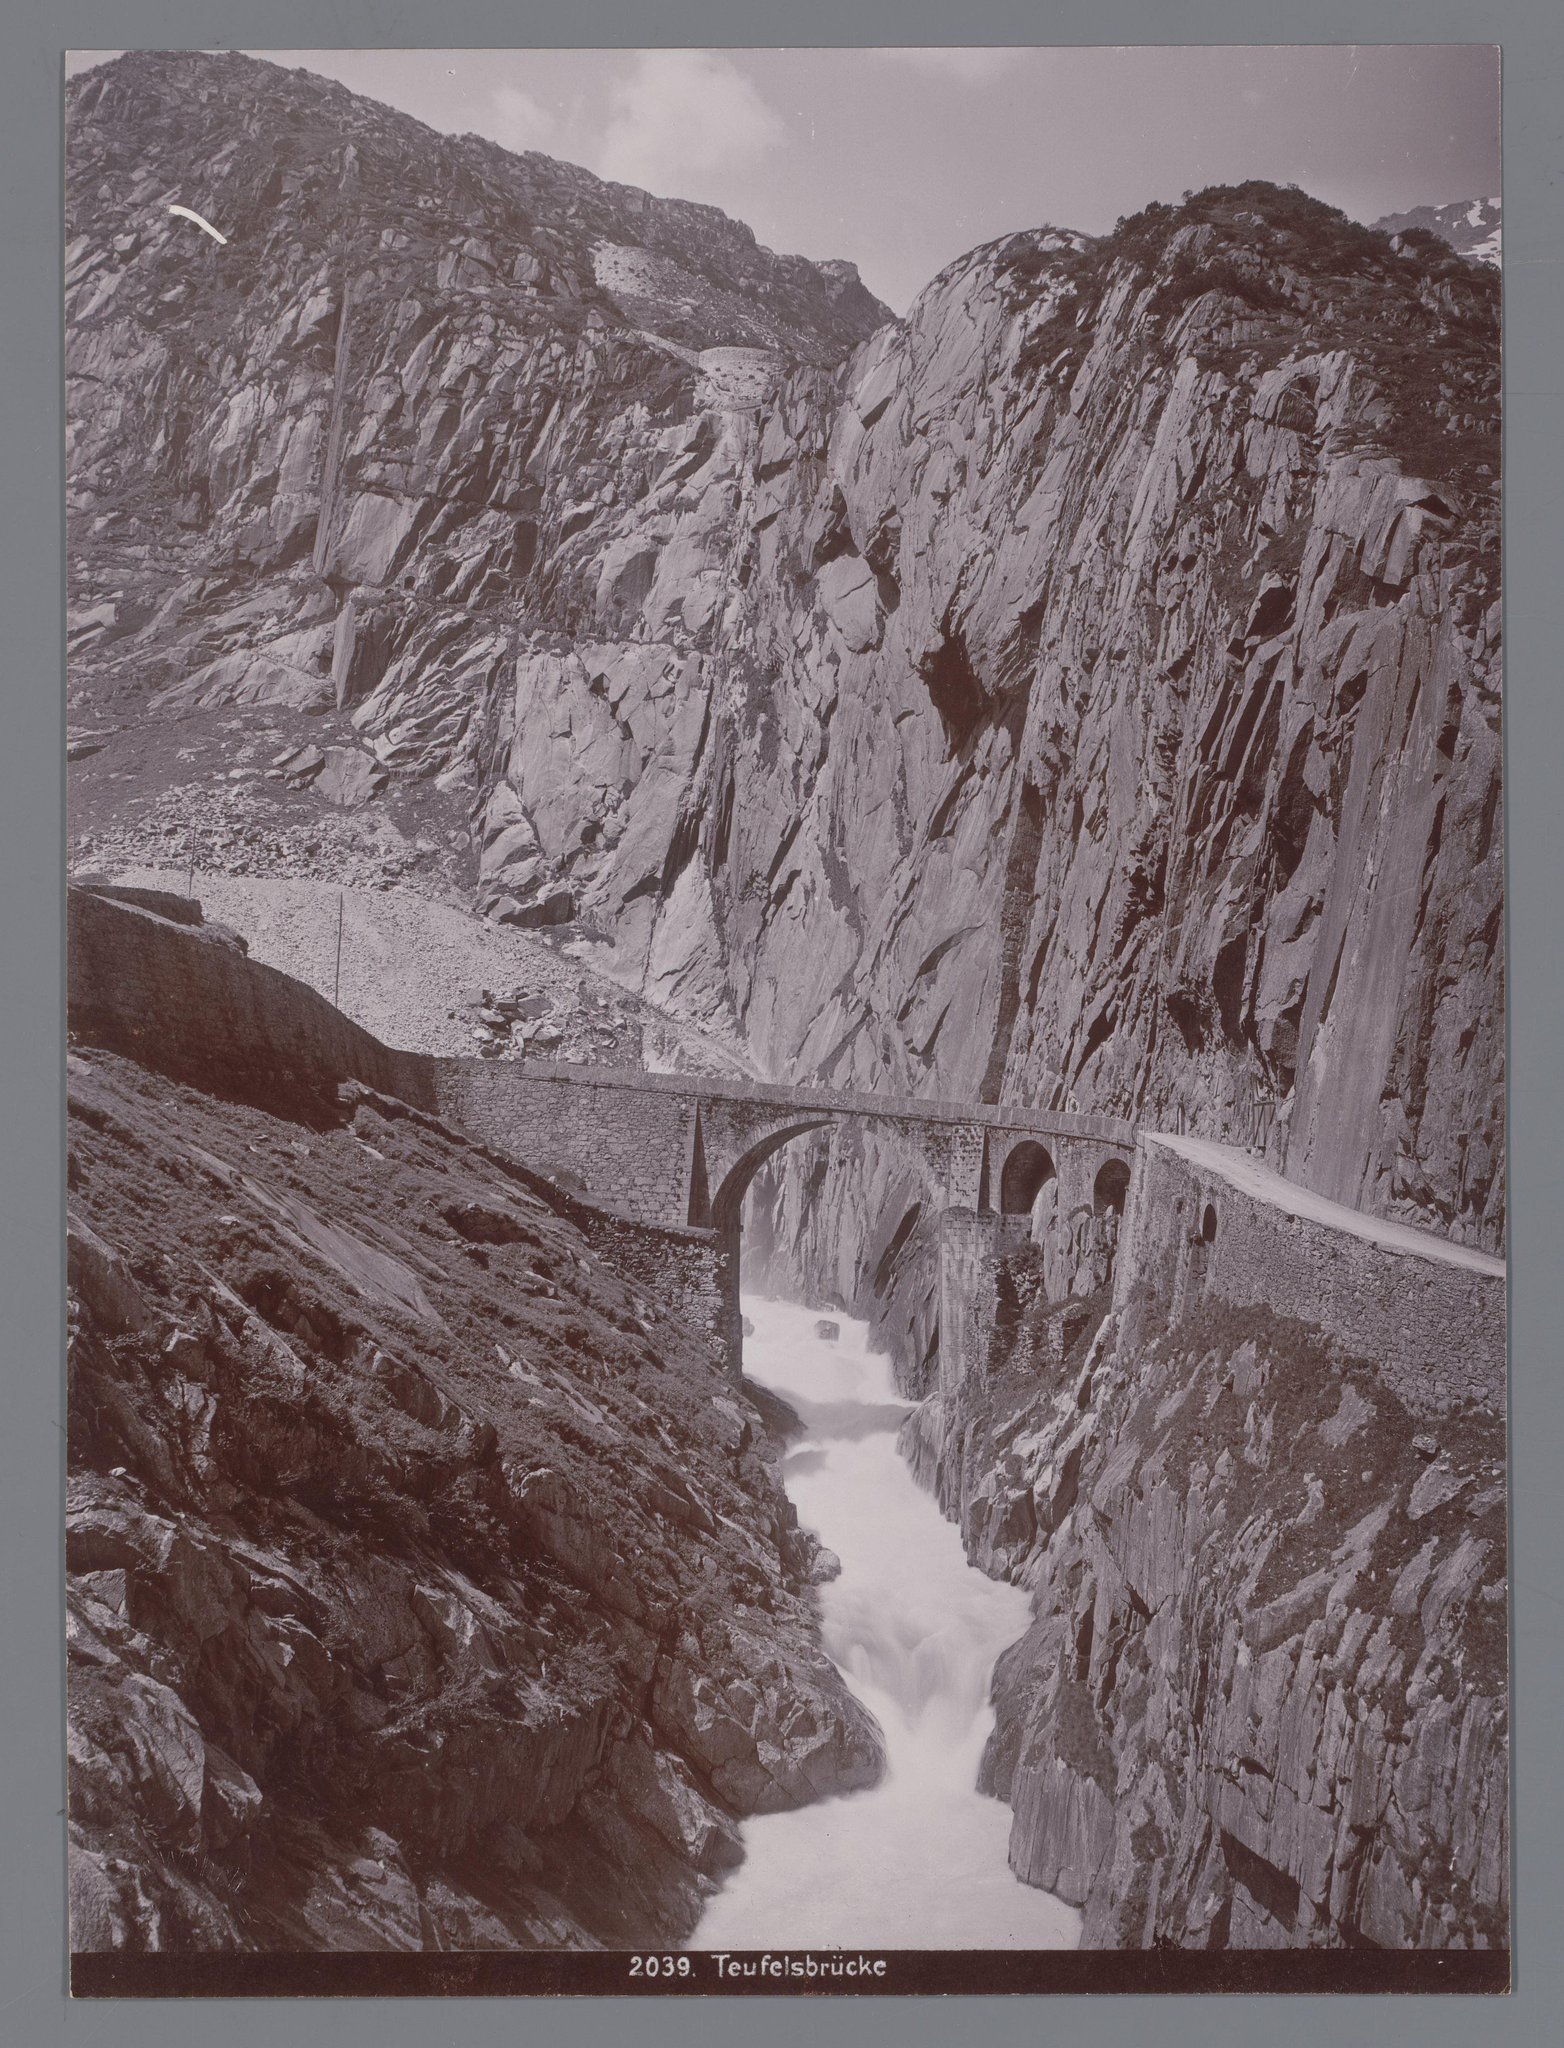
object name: photograph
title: Teufelsbrücke over de Schöllenenschlucht, bij de Gotthardpas, Zwitserland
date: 1900-1920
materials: cardboard, paper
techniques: gelatin silver print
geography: switzerland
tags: switzerland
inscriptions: inscription: ‘2039 Teufelsbrücke’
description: Brug over de Schöllenenschlucht, bij de Gotthardpass tussen Göschenen in het Noorden en Andermatt in het Zuiden (kanton Uri). Ertussen stroomt de rivier Reuss. De Gotthardpas verbindt kanton Uri met kanton Tessin. Vergelijk RP-F-00-6194 en RP-F-00-6222.